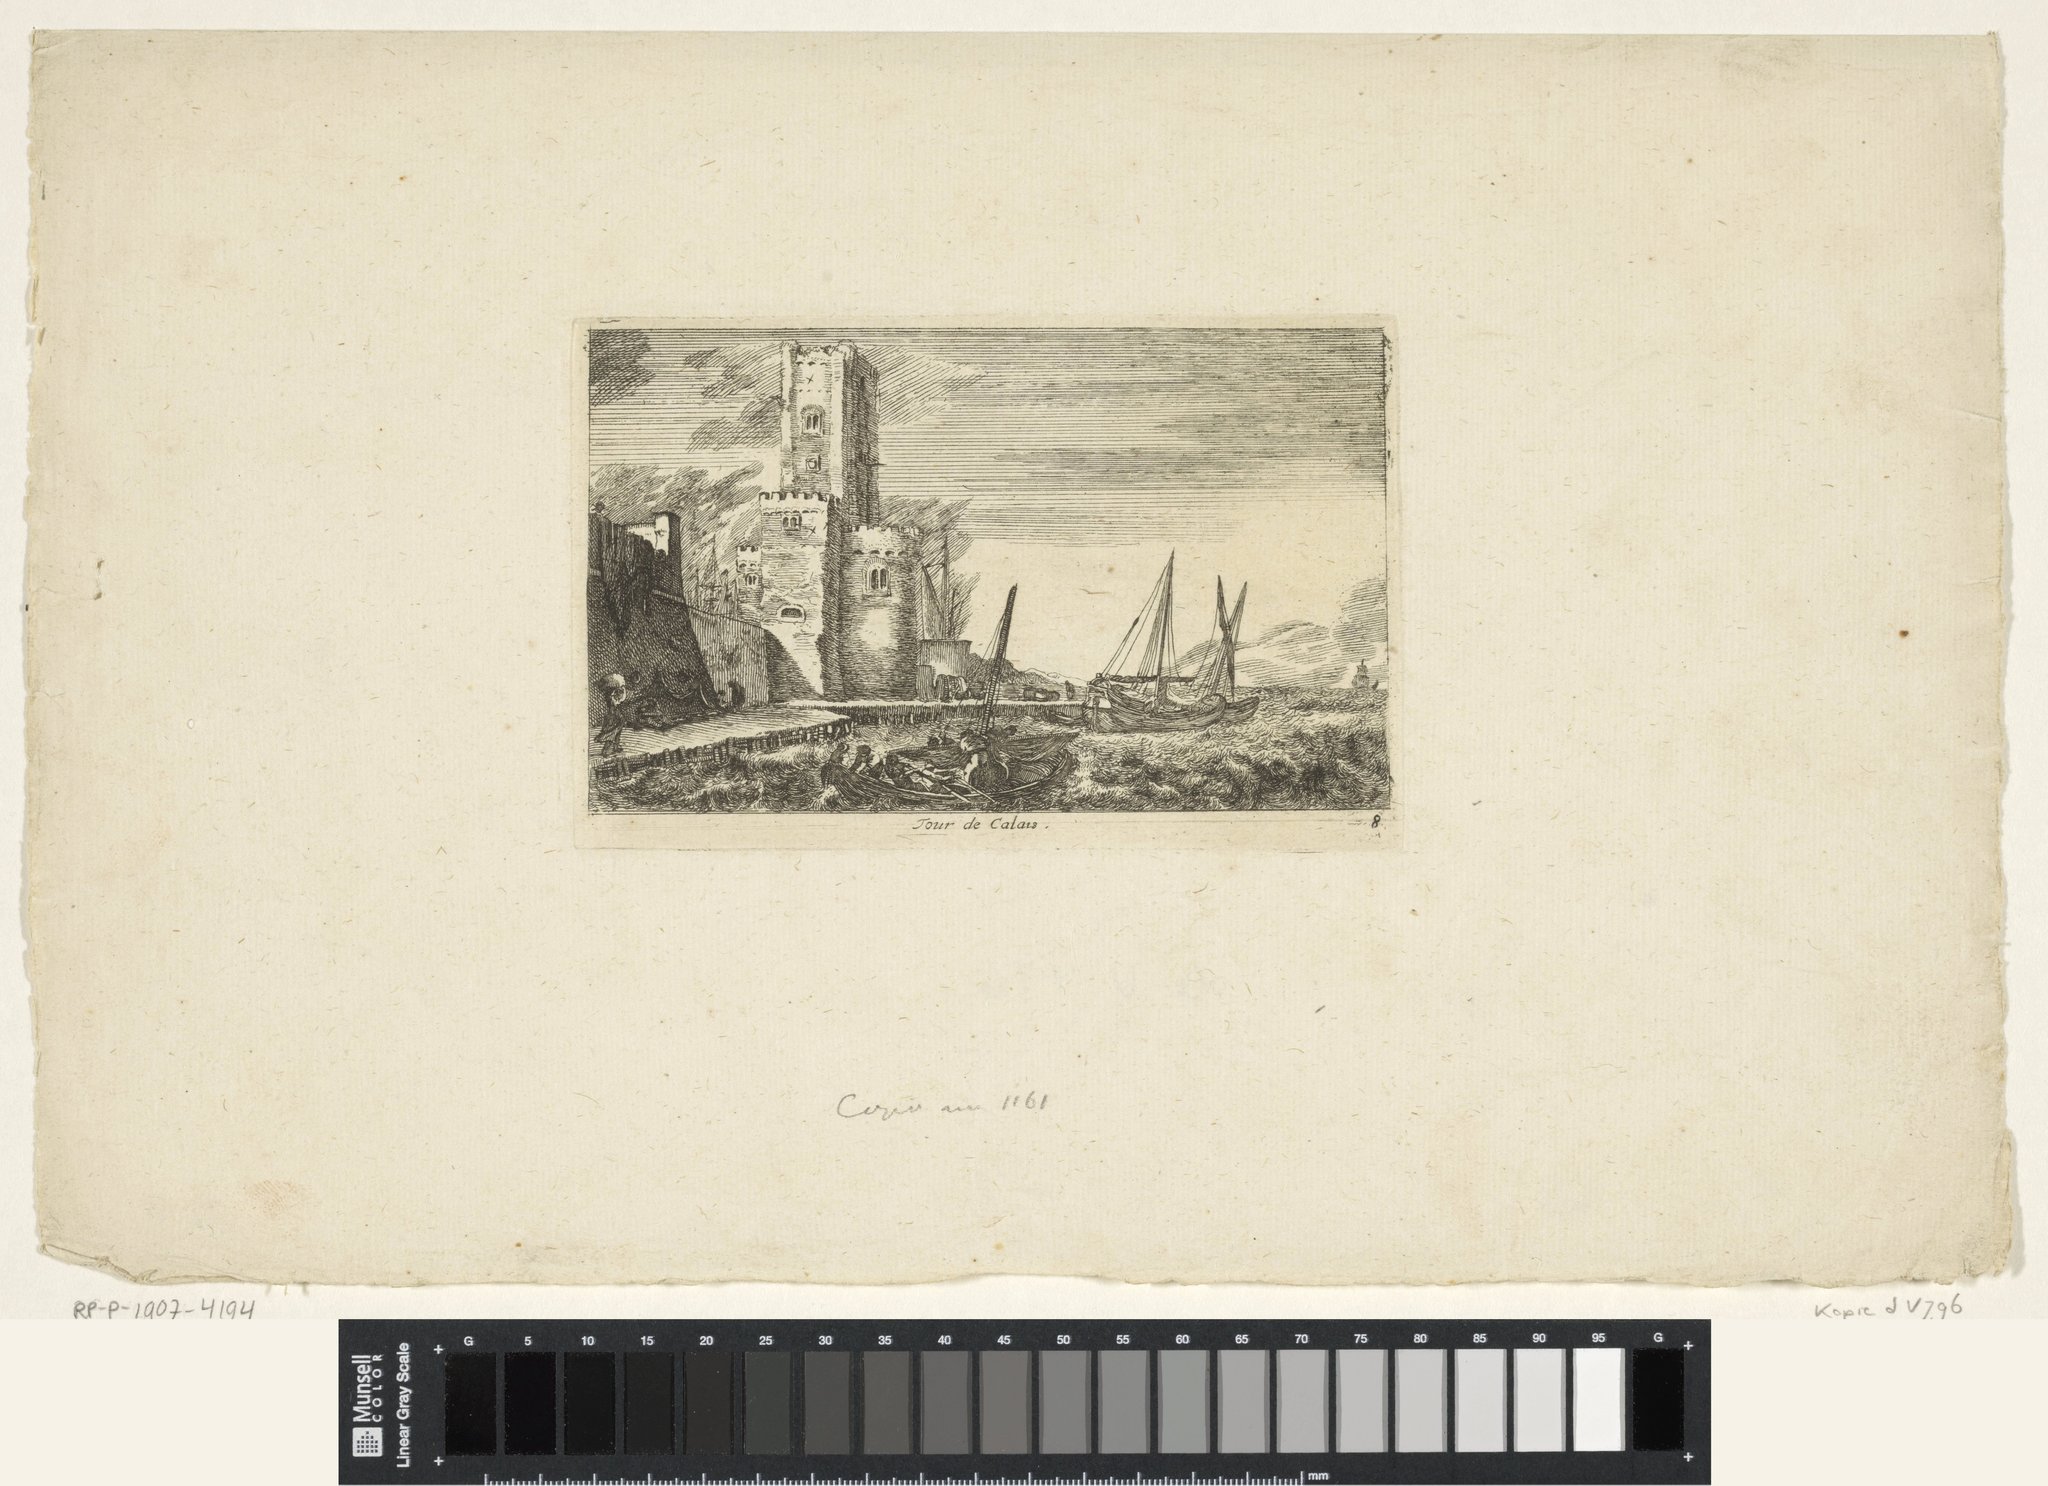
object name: print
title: Vues de ports de mer (kopieën)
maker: Anonymous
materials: paper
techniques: etching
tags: harbour, ships (in general)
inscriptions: collector's mark: Lugt 2228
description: De haven van Calais met op de kust een muur en een toren. In de haven liggen drie zeilboten.